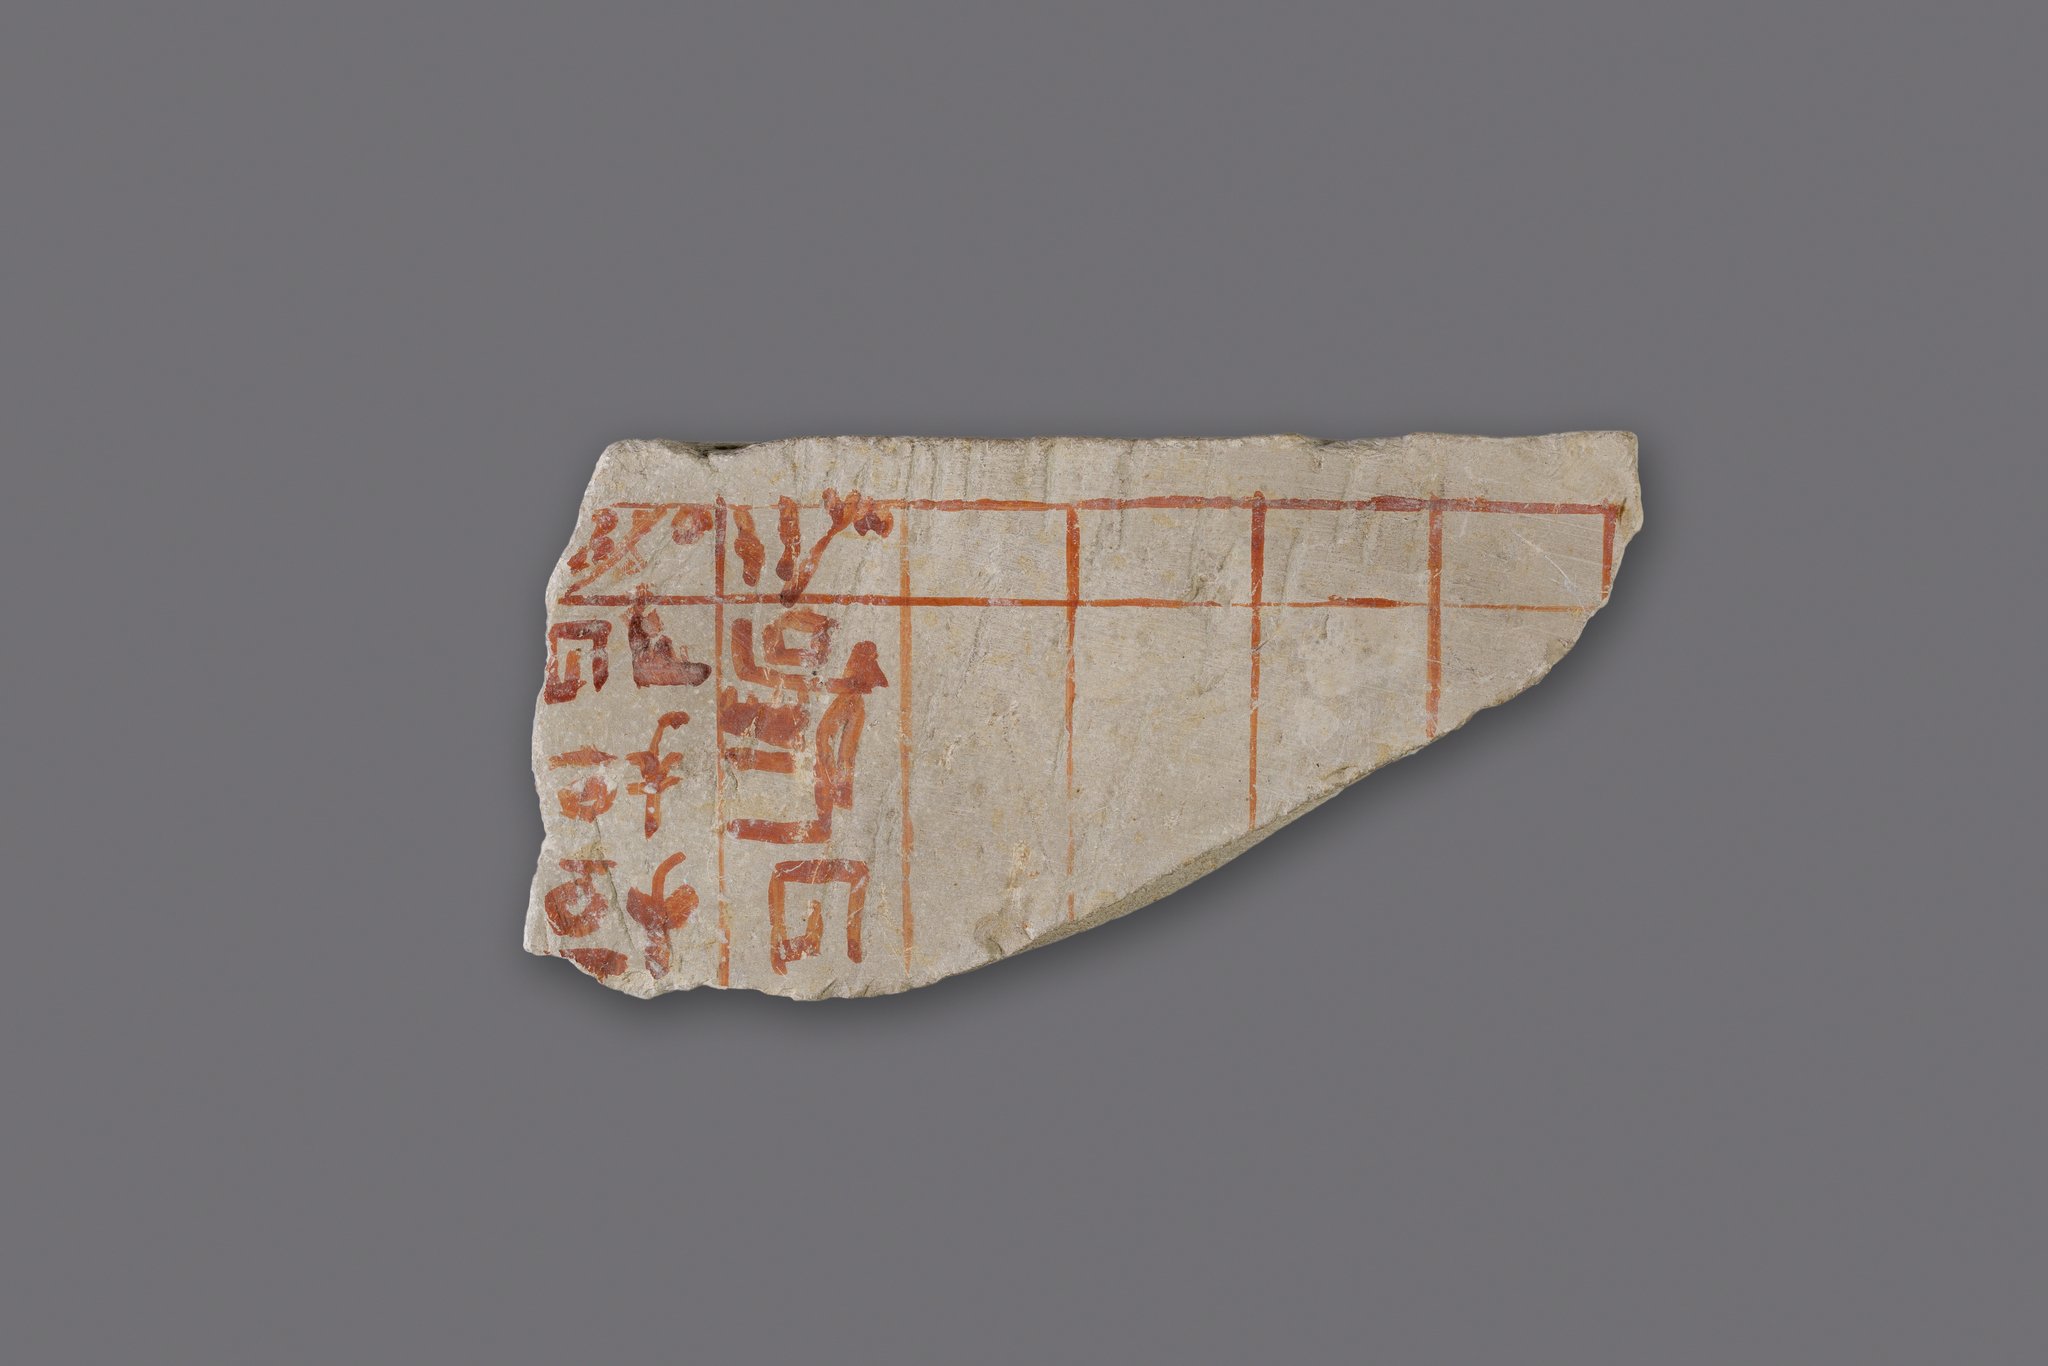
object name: ostracon, hieratic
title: Ostracon with a grid giving days of the months in hieratic against names and locations in hieroglyphs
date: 664-610 BCE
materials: ink, limestone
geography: egypt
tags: hieratic